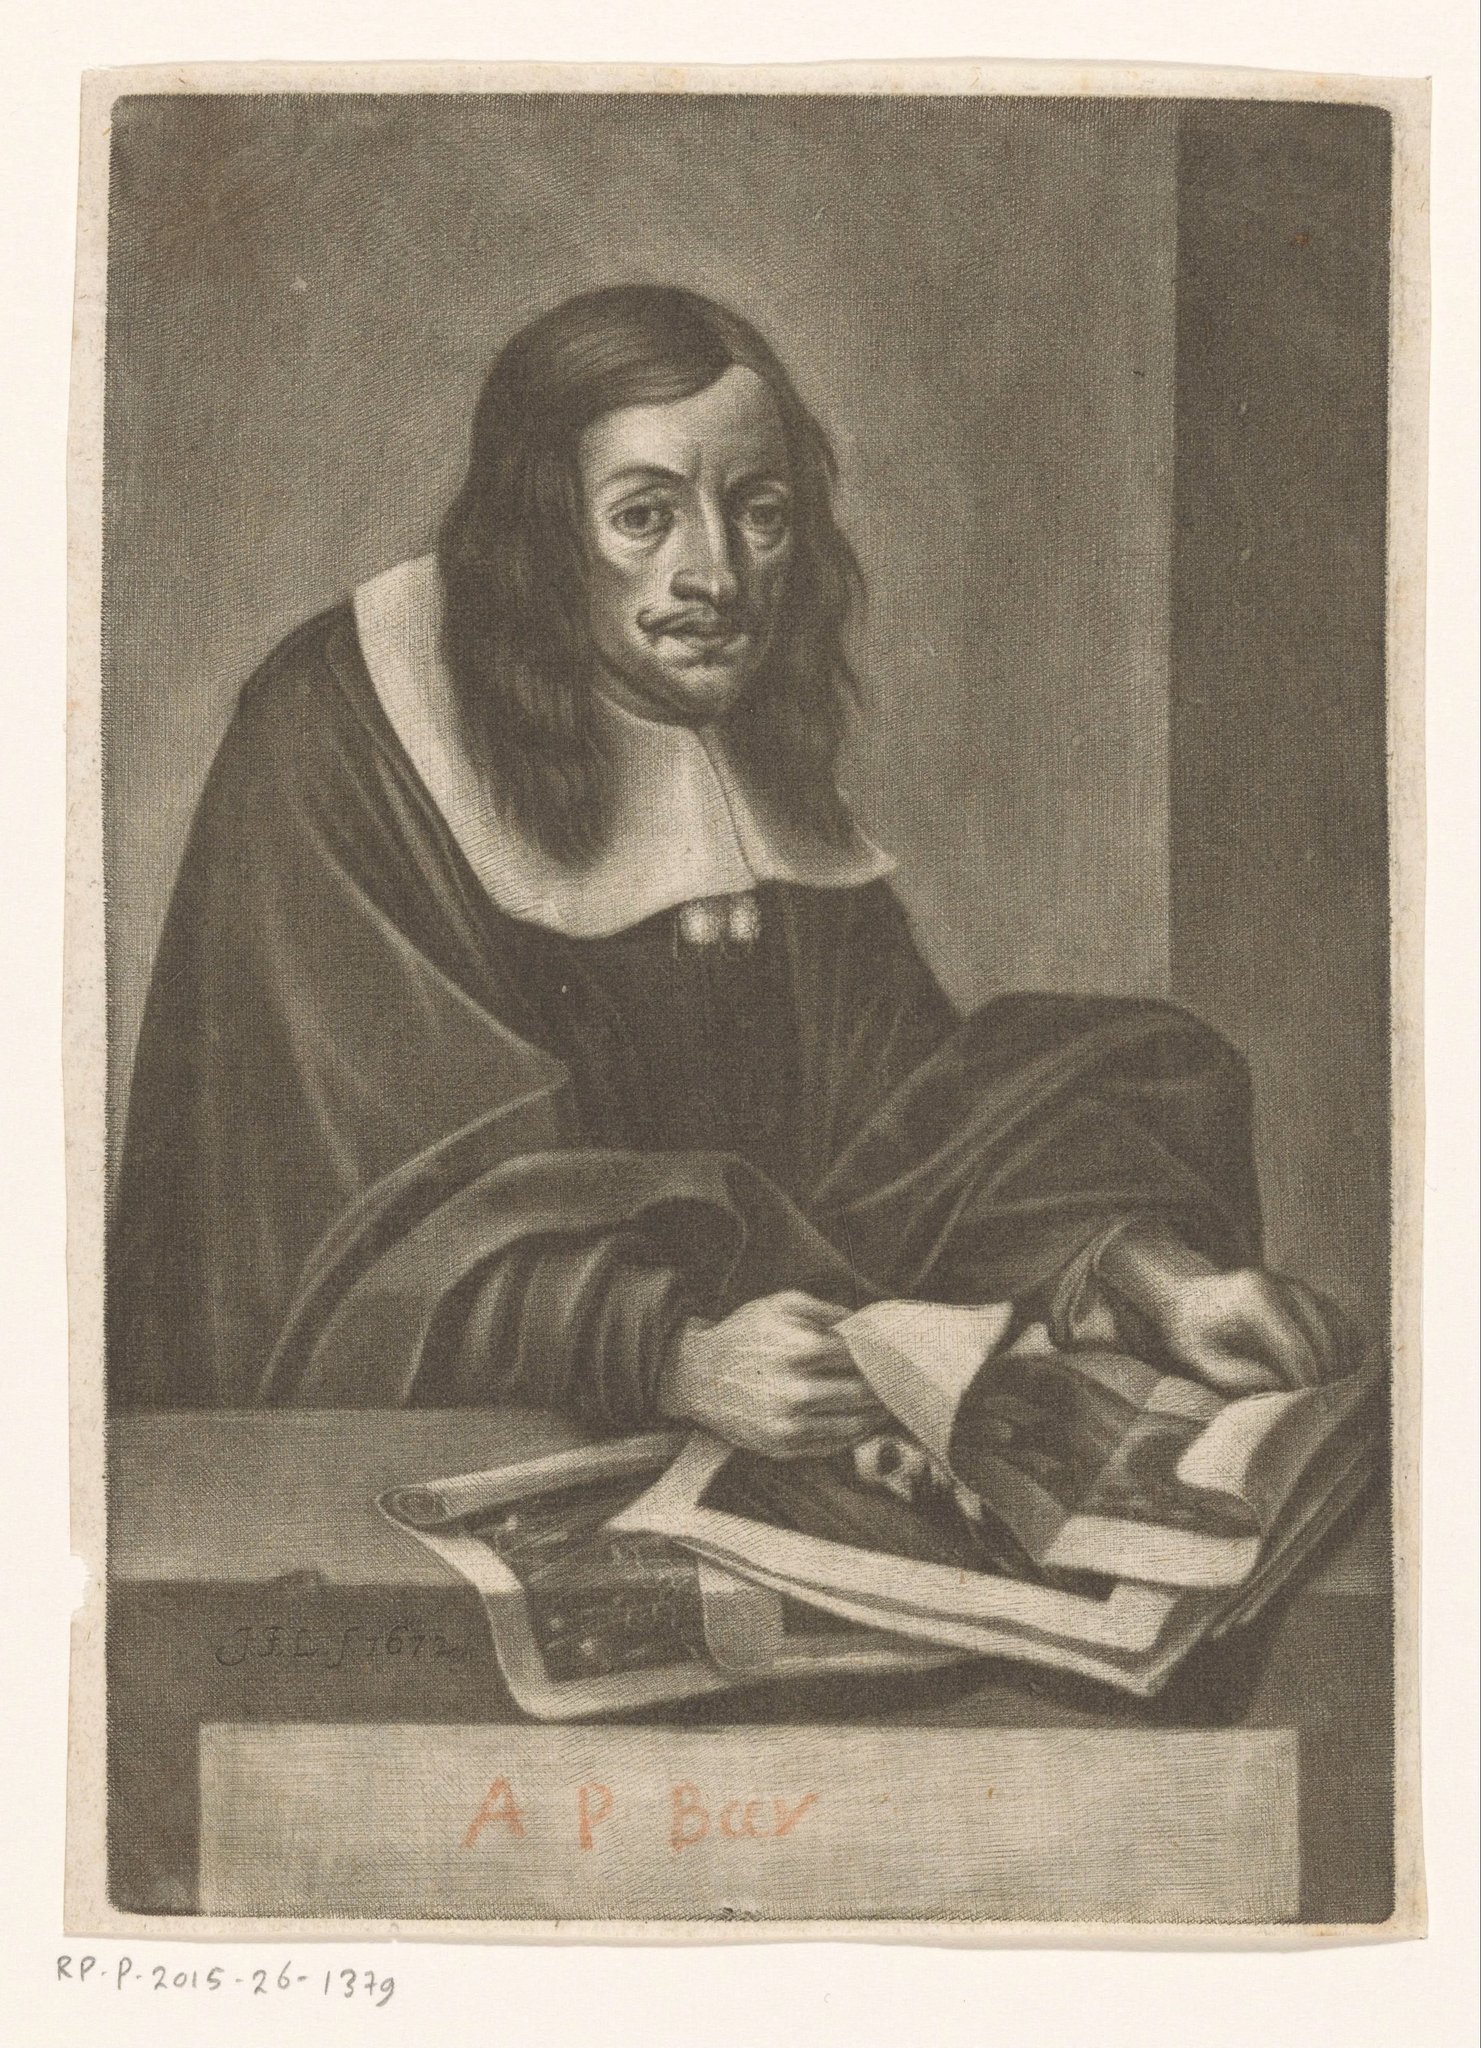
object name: print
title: Portret van Andreas Paul Beer, boekhandelaar te Neurenberg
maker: johann friedrich leonard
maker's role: print maker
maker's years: 1633-1680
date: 1672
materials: paper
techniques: mezzotint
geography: nuremberg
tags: print, e.g.: engraving, etching, lithograph, book-shop, bookseller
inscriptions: collector's mark: Lugt 2228, collector's mark: Lugt 4780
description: Portret van Andreas Paul Beer in een nis met voor zich een stapel prenten.